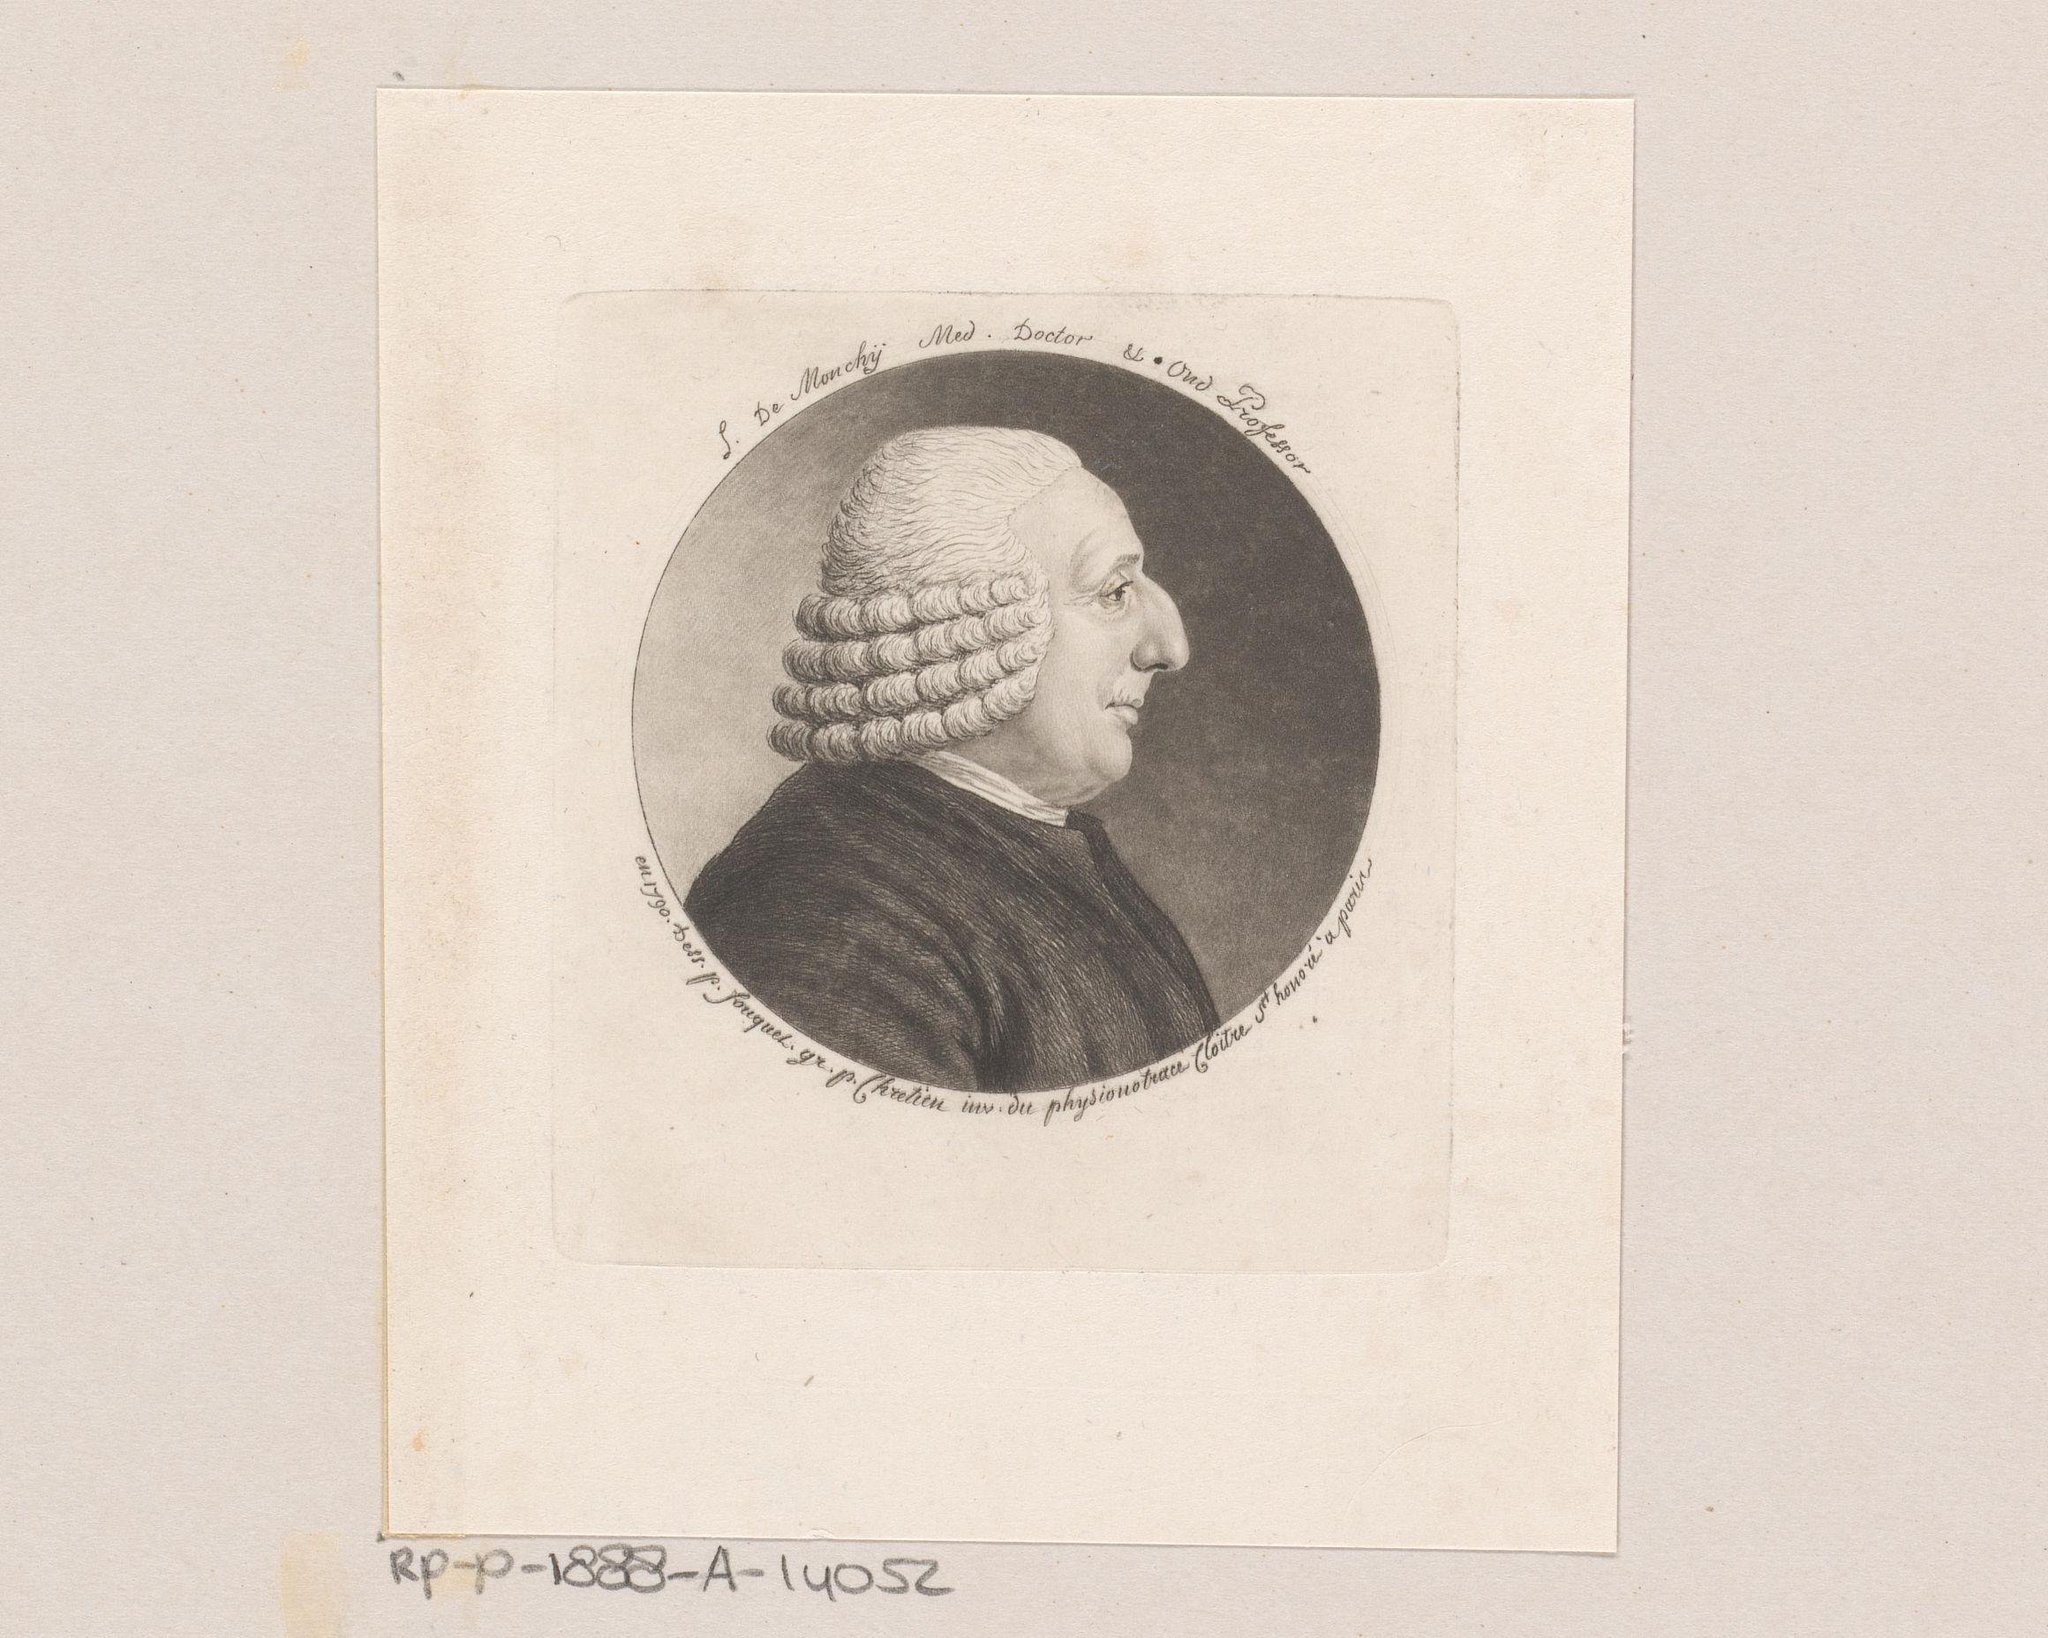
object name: physionotrace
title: Portret van Salomon de Monchy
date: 1790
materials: paper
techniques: aquatint, etching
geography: paris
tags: rotterdam, amsterdam, historical persons, professor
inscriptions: collector's mark: Lugt 2227